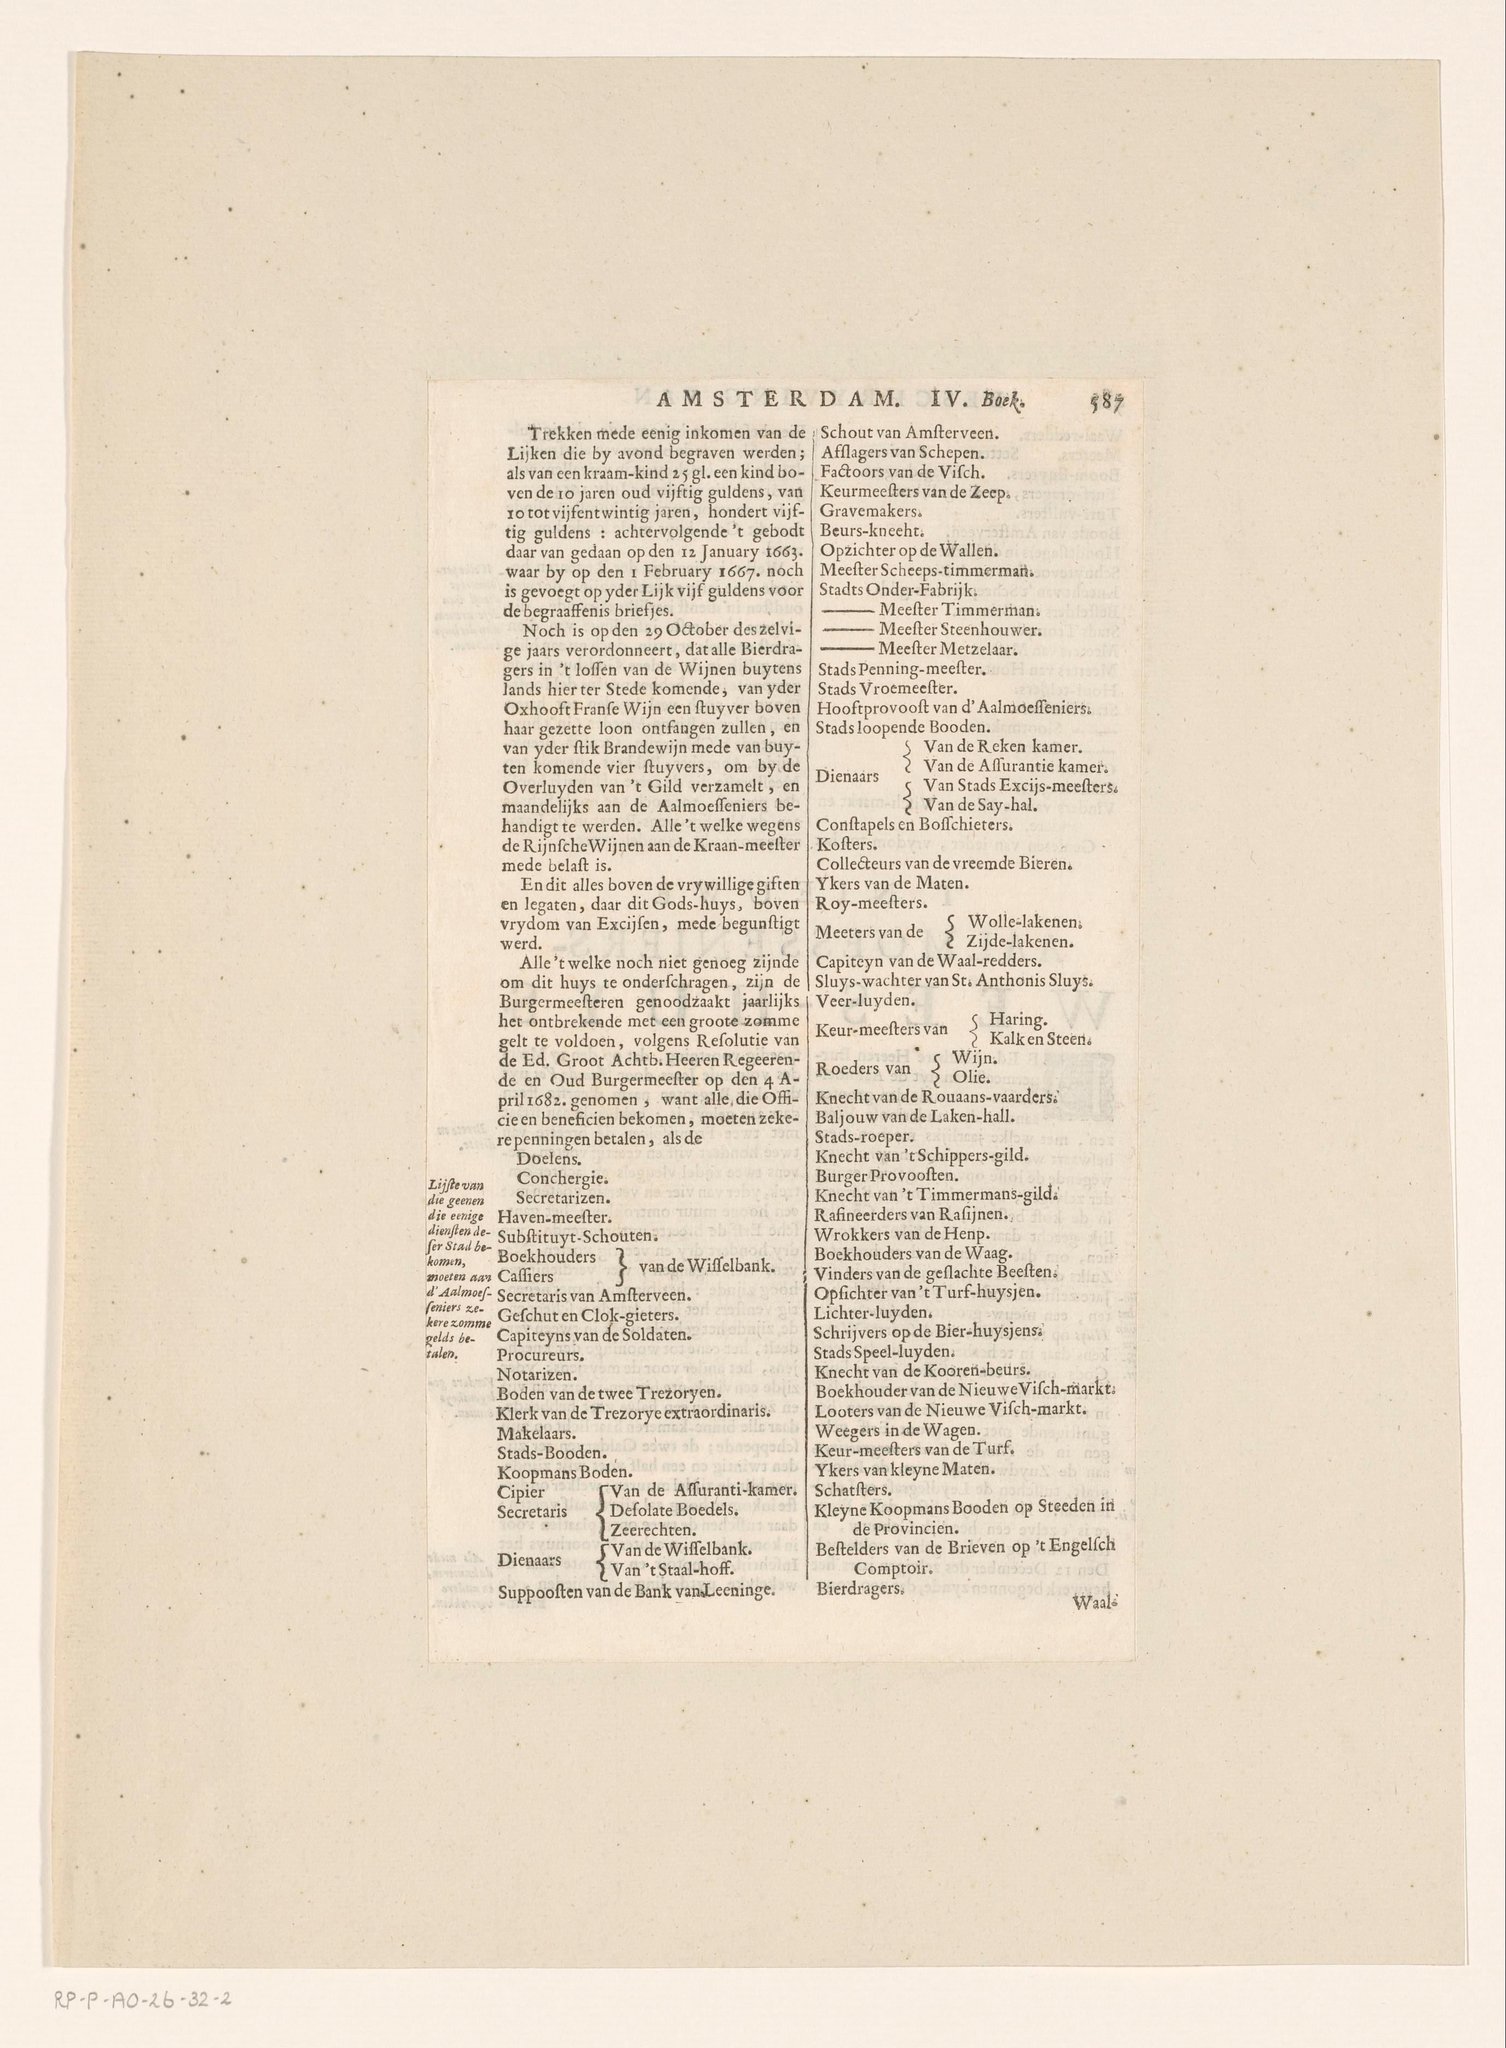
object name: text sheet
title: Deel van een beschrijving van het Aalmoezeniershuis en het Aalmoezeniersweeshuis te Amsterdam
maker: caspar commelin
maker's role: botanicus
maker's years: 1668-1731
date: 1693-1694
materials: paper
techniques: letterpress printing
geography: amsterdam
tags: orphanage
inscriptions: collector's mark: Lugt 2228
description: Tekst gebruikt in: Commelin, Caspar. Beschryvinge van Amsterdam, desselfs eerste oorspronk uyt den Huyse (…). 2 delen. Amsterdam: Abraham Wolfgang, Gillis Janssonius van Waesberge, Johannes Janssonius van Waesberge II, weduwe Dirk Boom I, Hendrick Boom en Rembertus Goethals, 1693. Of in: Commelin, Caspar. Beschryvinge van Amsterdam, zynde een naukeurige verhandelinge van desselfs eerste oorspronk uyt (…). 2 delen. Amsterdam: weduwe Aart Dircksz Oossaan, 1694. Zelfde tekst, net anders vormgegeven (zeer onopvallende kleine details), ook gebruikt in: Commelin, Caspar. Beschryvinge van Amsterdam, zynde een naukeurige verhandelinge van desselfs eerste oorspronk uyt (…). 2 delen. 2e druk. Amsterdam: Andries van Damme, Johannes Ratelband, weduwe A. van Aaltwyk en Hermanus Uytwerf, 1726. Zie RP-P-AO-26-32-1, RP-P-AO-26-32-3 en RP-P-AO-26-32-4 voor de rest van de beschrijving. Zie RP-P-AO-26-32-5 voor de bijhorende afbeelding van het Aalmoezeniersweeshuis.